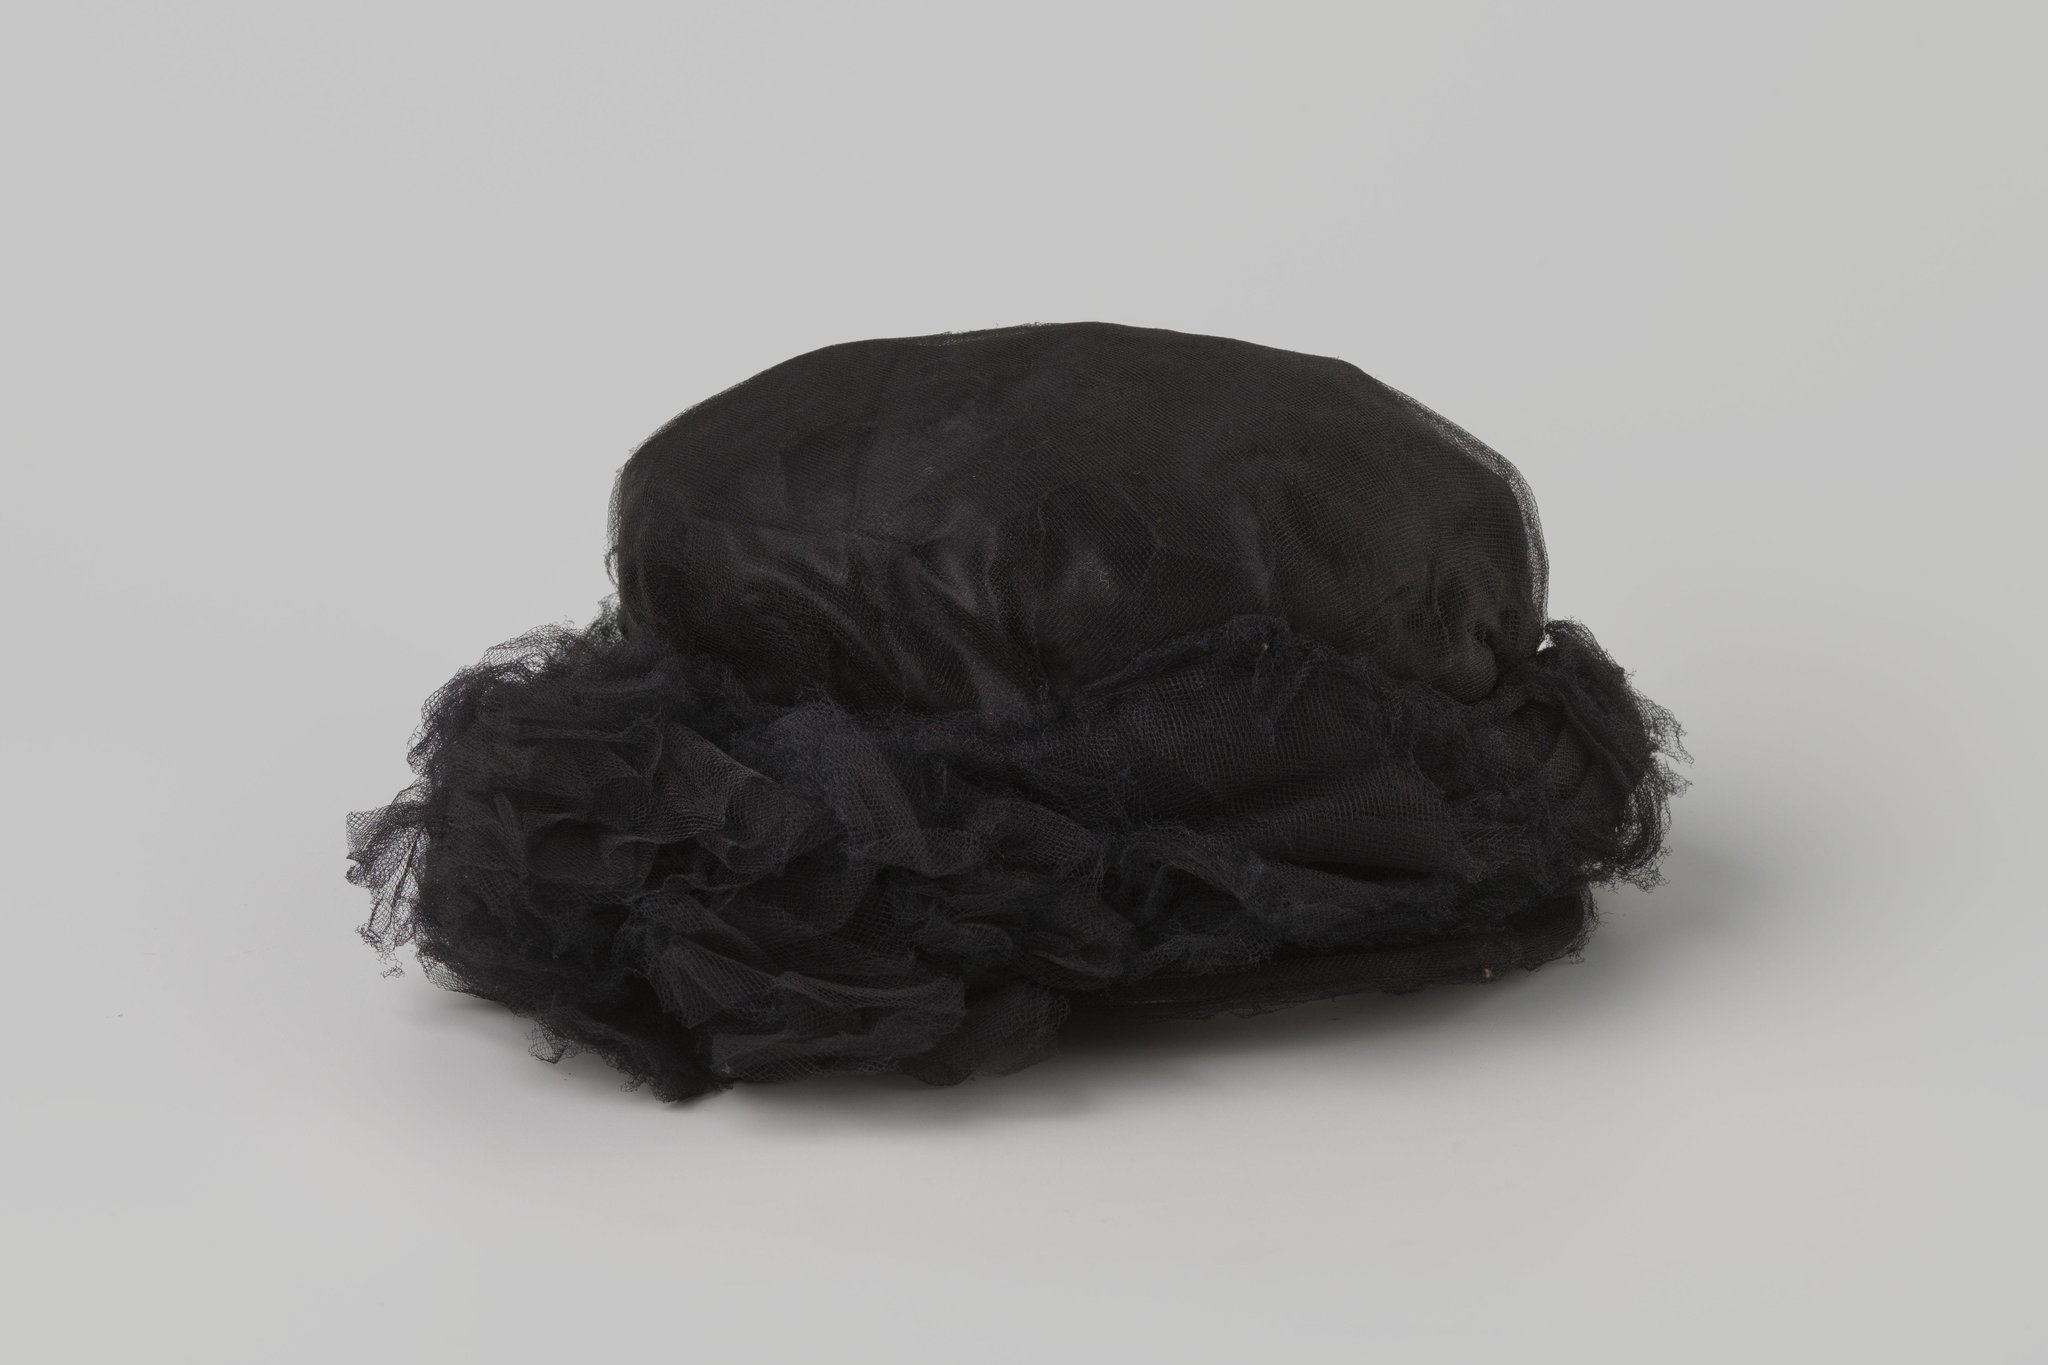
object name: womenswear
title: Hoed van zwarte tule en satijn met rechts een toef tule, met hoedenspeld met peenvormige knop van stro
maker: Anonymous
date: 1905-1910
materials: metal, textile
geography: western europe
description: Hoed van zwarte tule en satijn. Vrij hoge, ronde bol van tule, over een satijnen fond, stijve binnenband, hieronder een kleine uitstaande tule rand, in de vorm gehouden door een laitoncirkel. Van dezelfde soort tule zijn gefronselde stroken op de rand gelegd. Rechts is een dikke toef tule gehecht. Met zwarte hoedenspeld met een peenvormig knopje van stro.